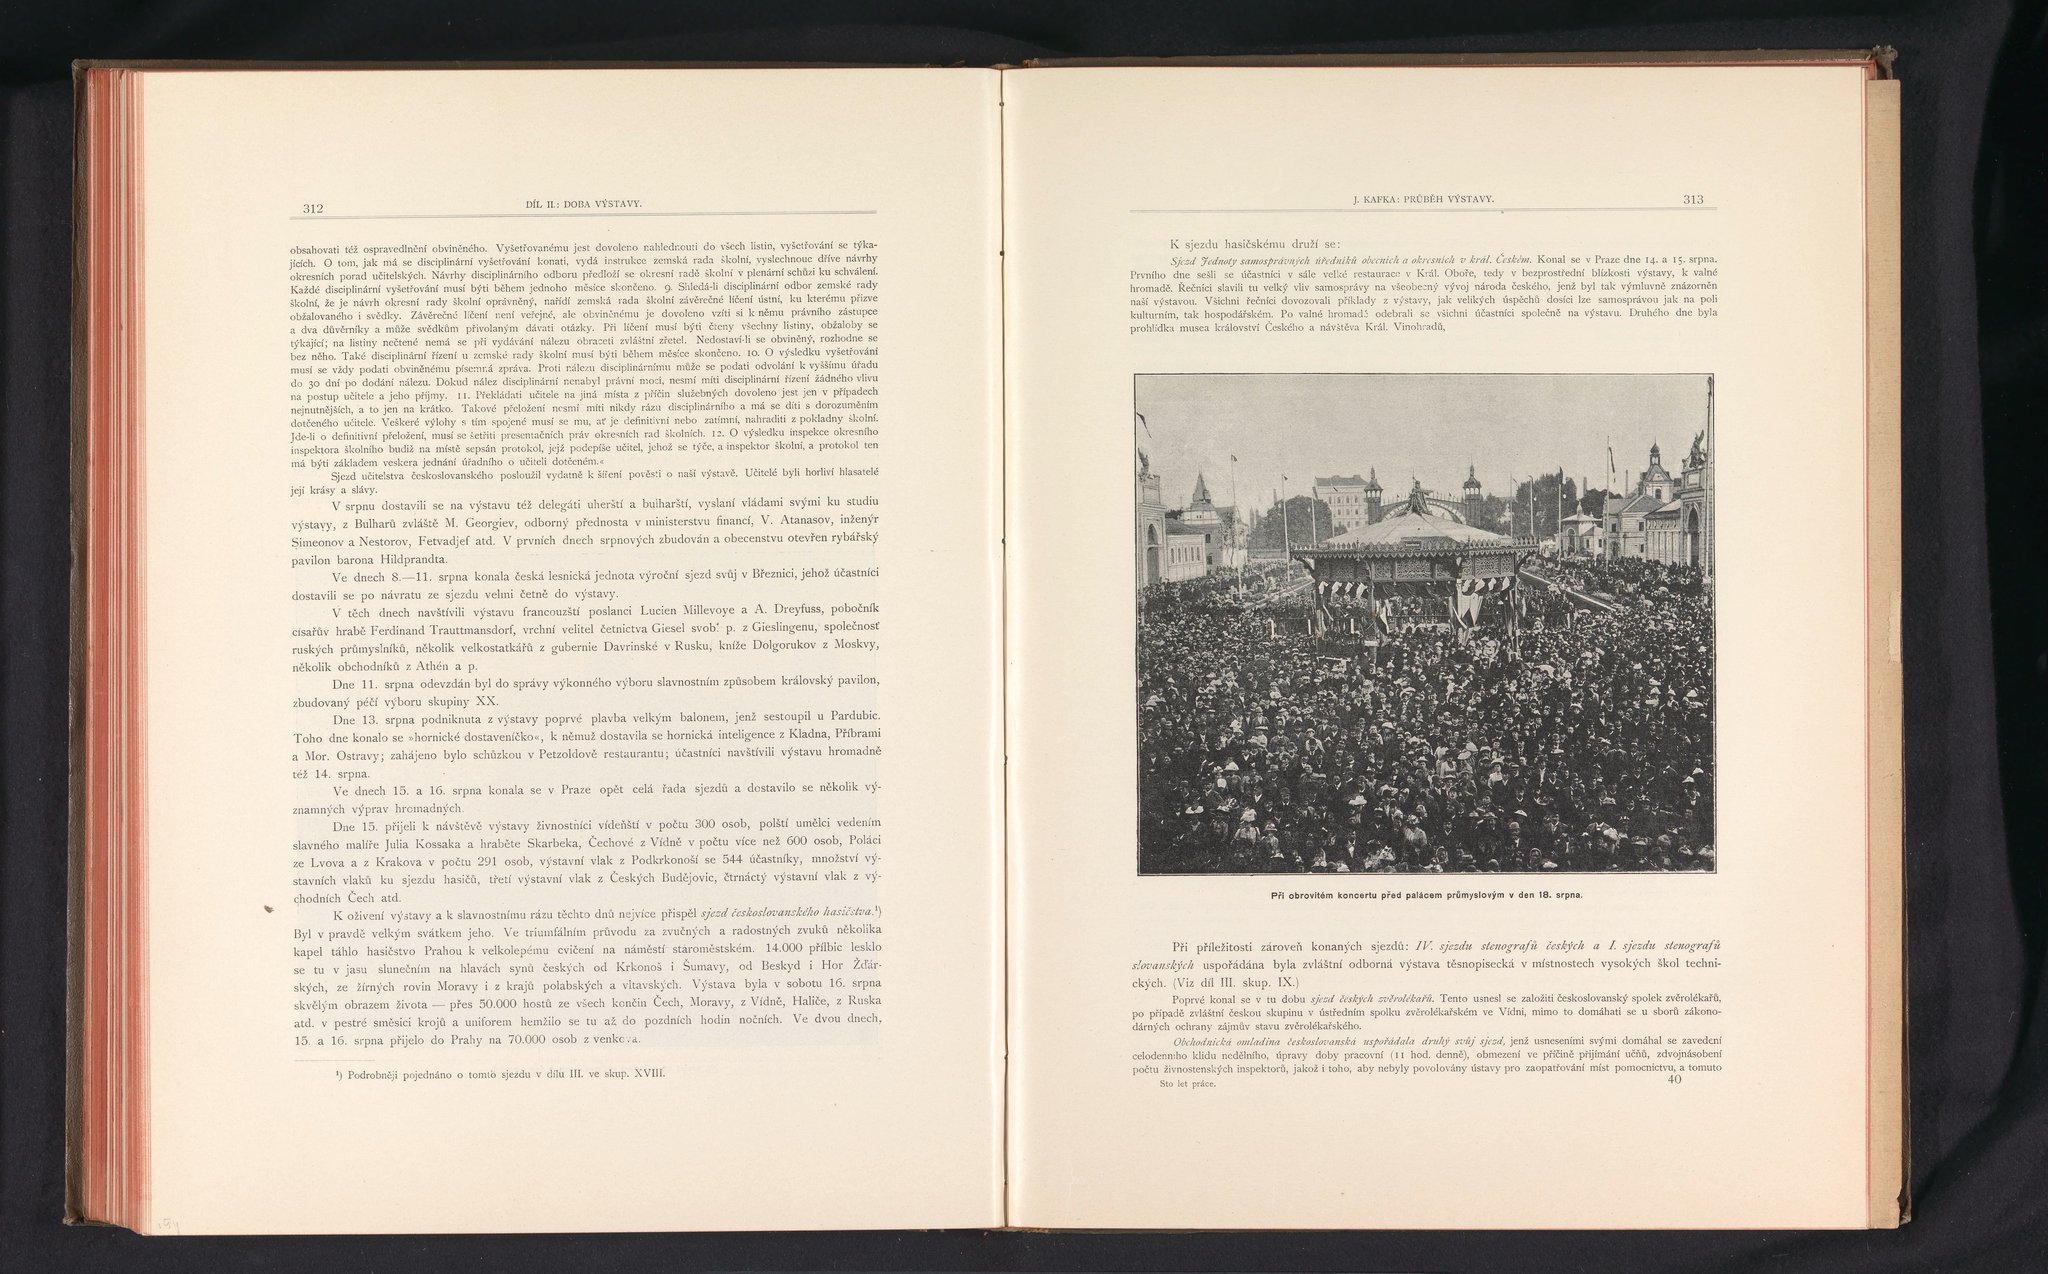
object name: page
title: Gezicht op een menigte tijdens een concert op het Výstaviště te Praag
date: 1891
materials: paper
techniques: autotype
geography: prague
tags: listening to music - cc - out of doors, temporary exhibition, 'salon'